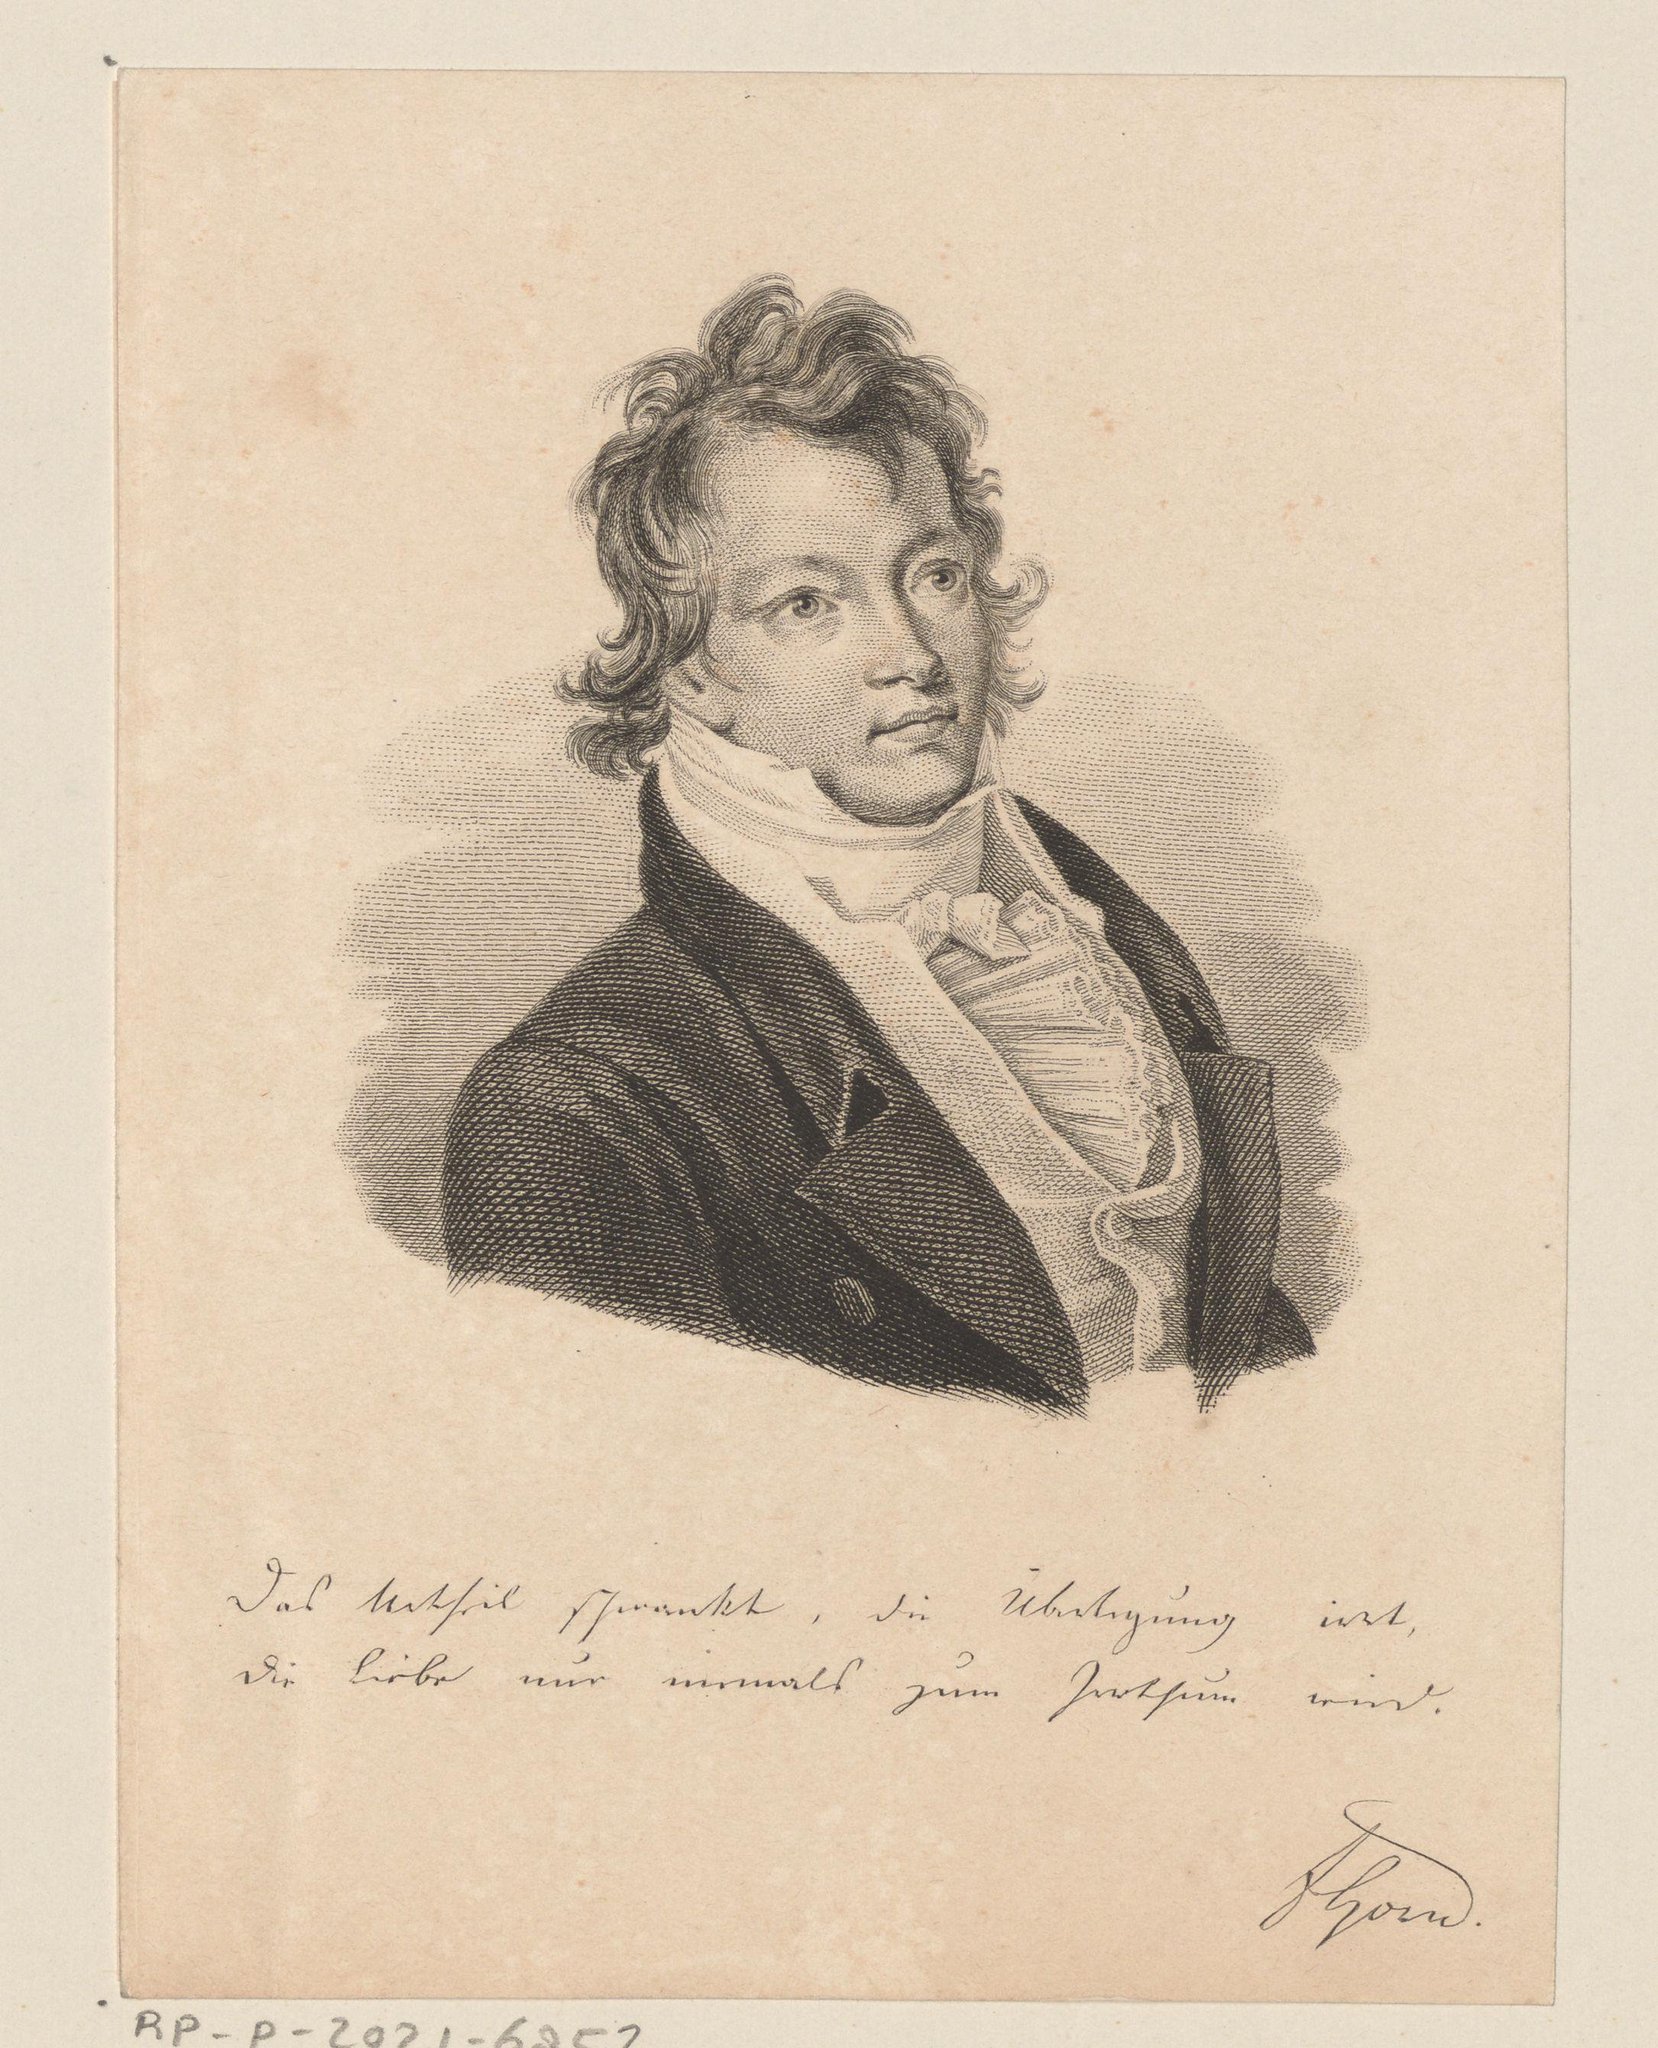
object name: print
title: Portret van Franz Horn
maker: Anonymous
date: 1825-1849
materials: paper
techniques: etching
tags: berlin, historical persons, portrait of a writer